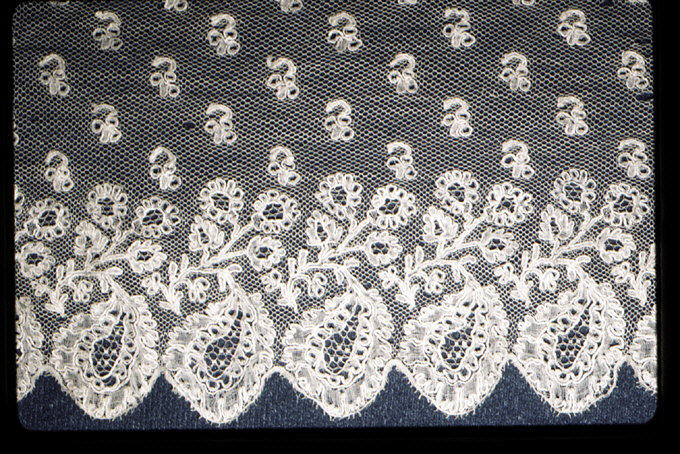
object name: fragment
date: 1800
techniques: lace